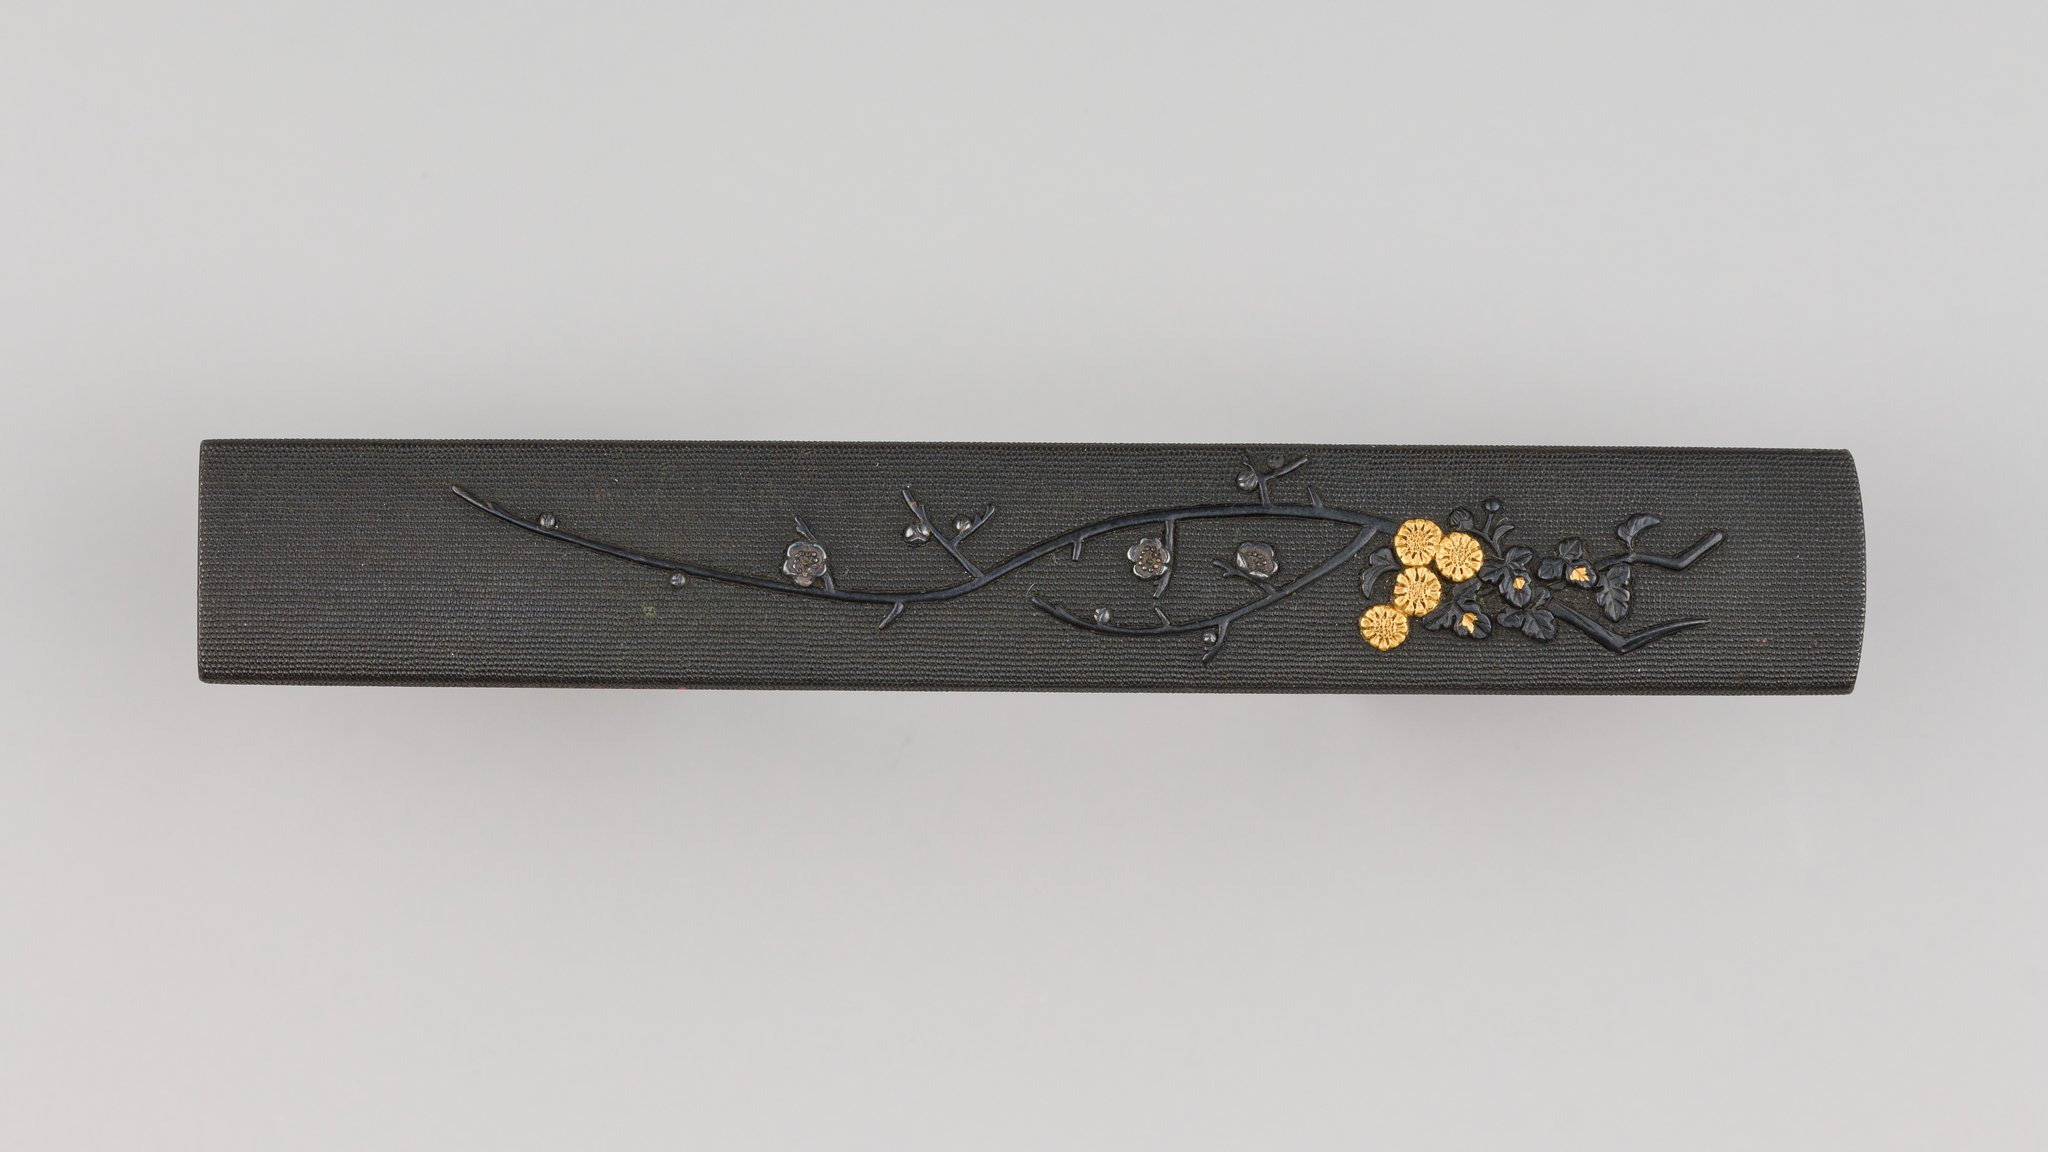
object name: knife handle kozuka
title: Knife Handle (Kozuka)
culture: japanese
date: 1801-1900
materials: gold alloy, gold, silver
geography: japan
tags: flowers